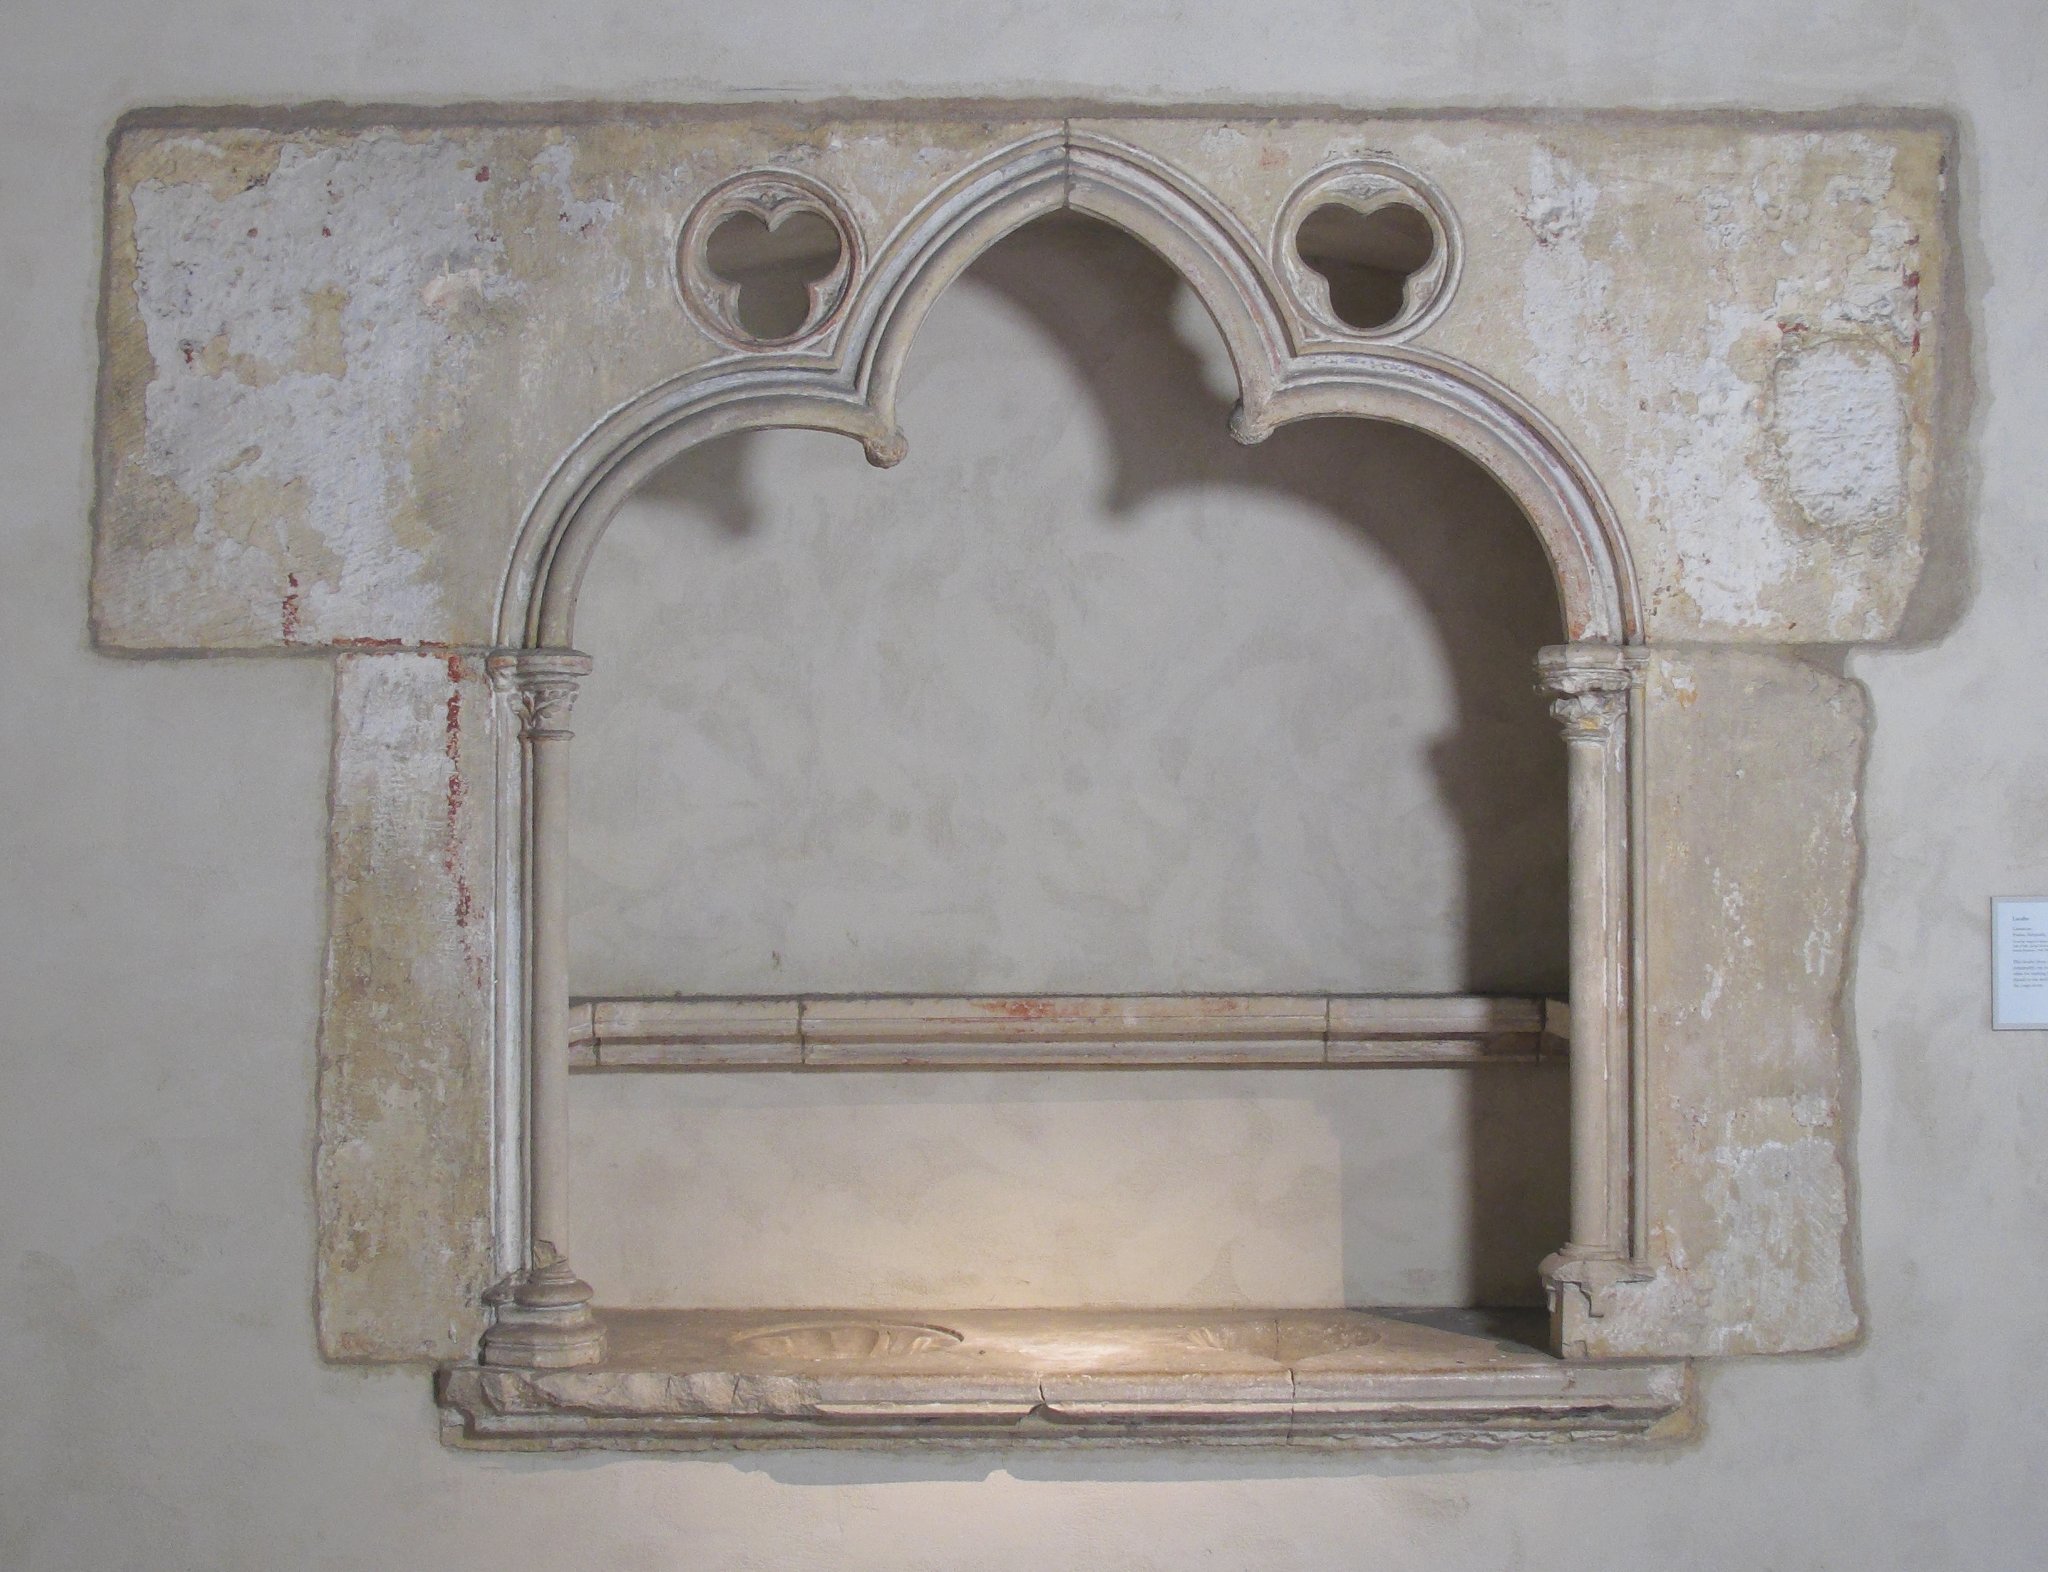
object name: lavabo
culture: french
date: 1201-1300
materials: limestone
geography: france